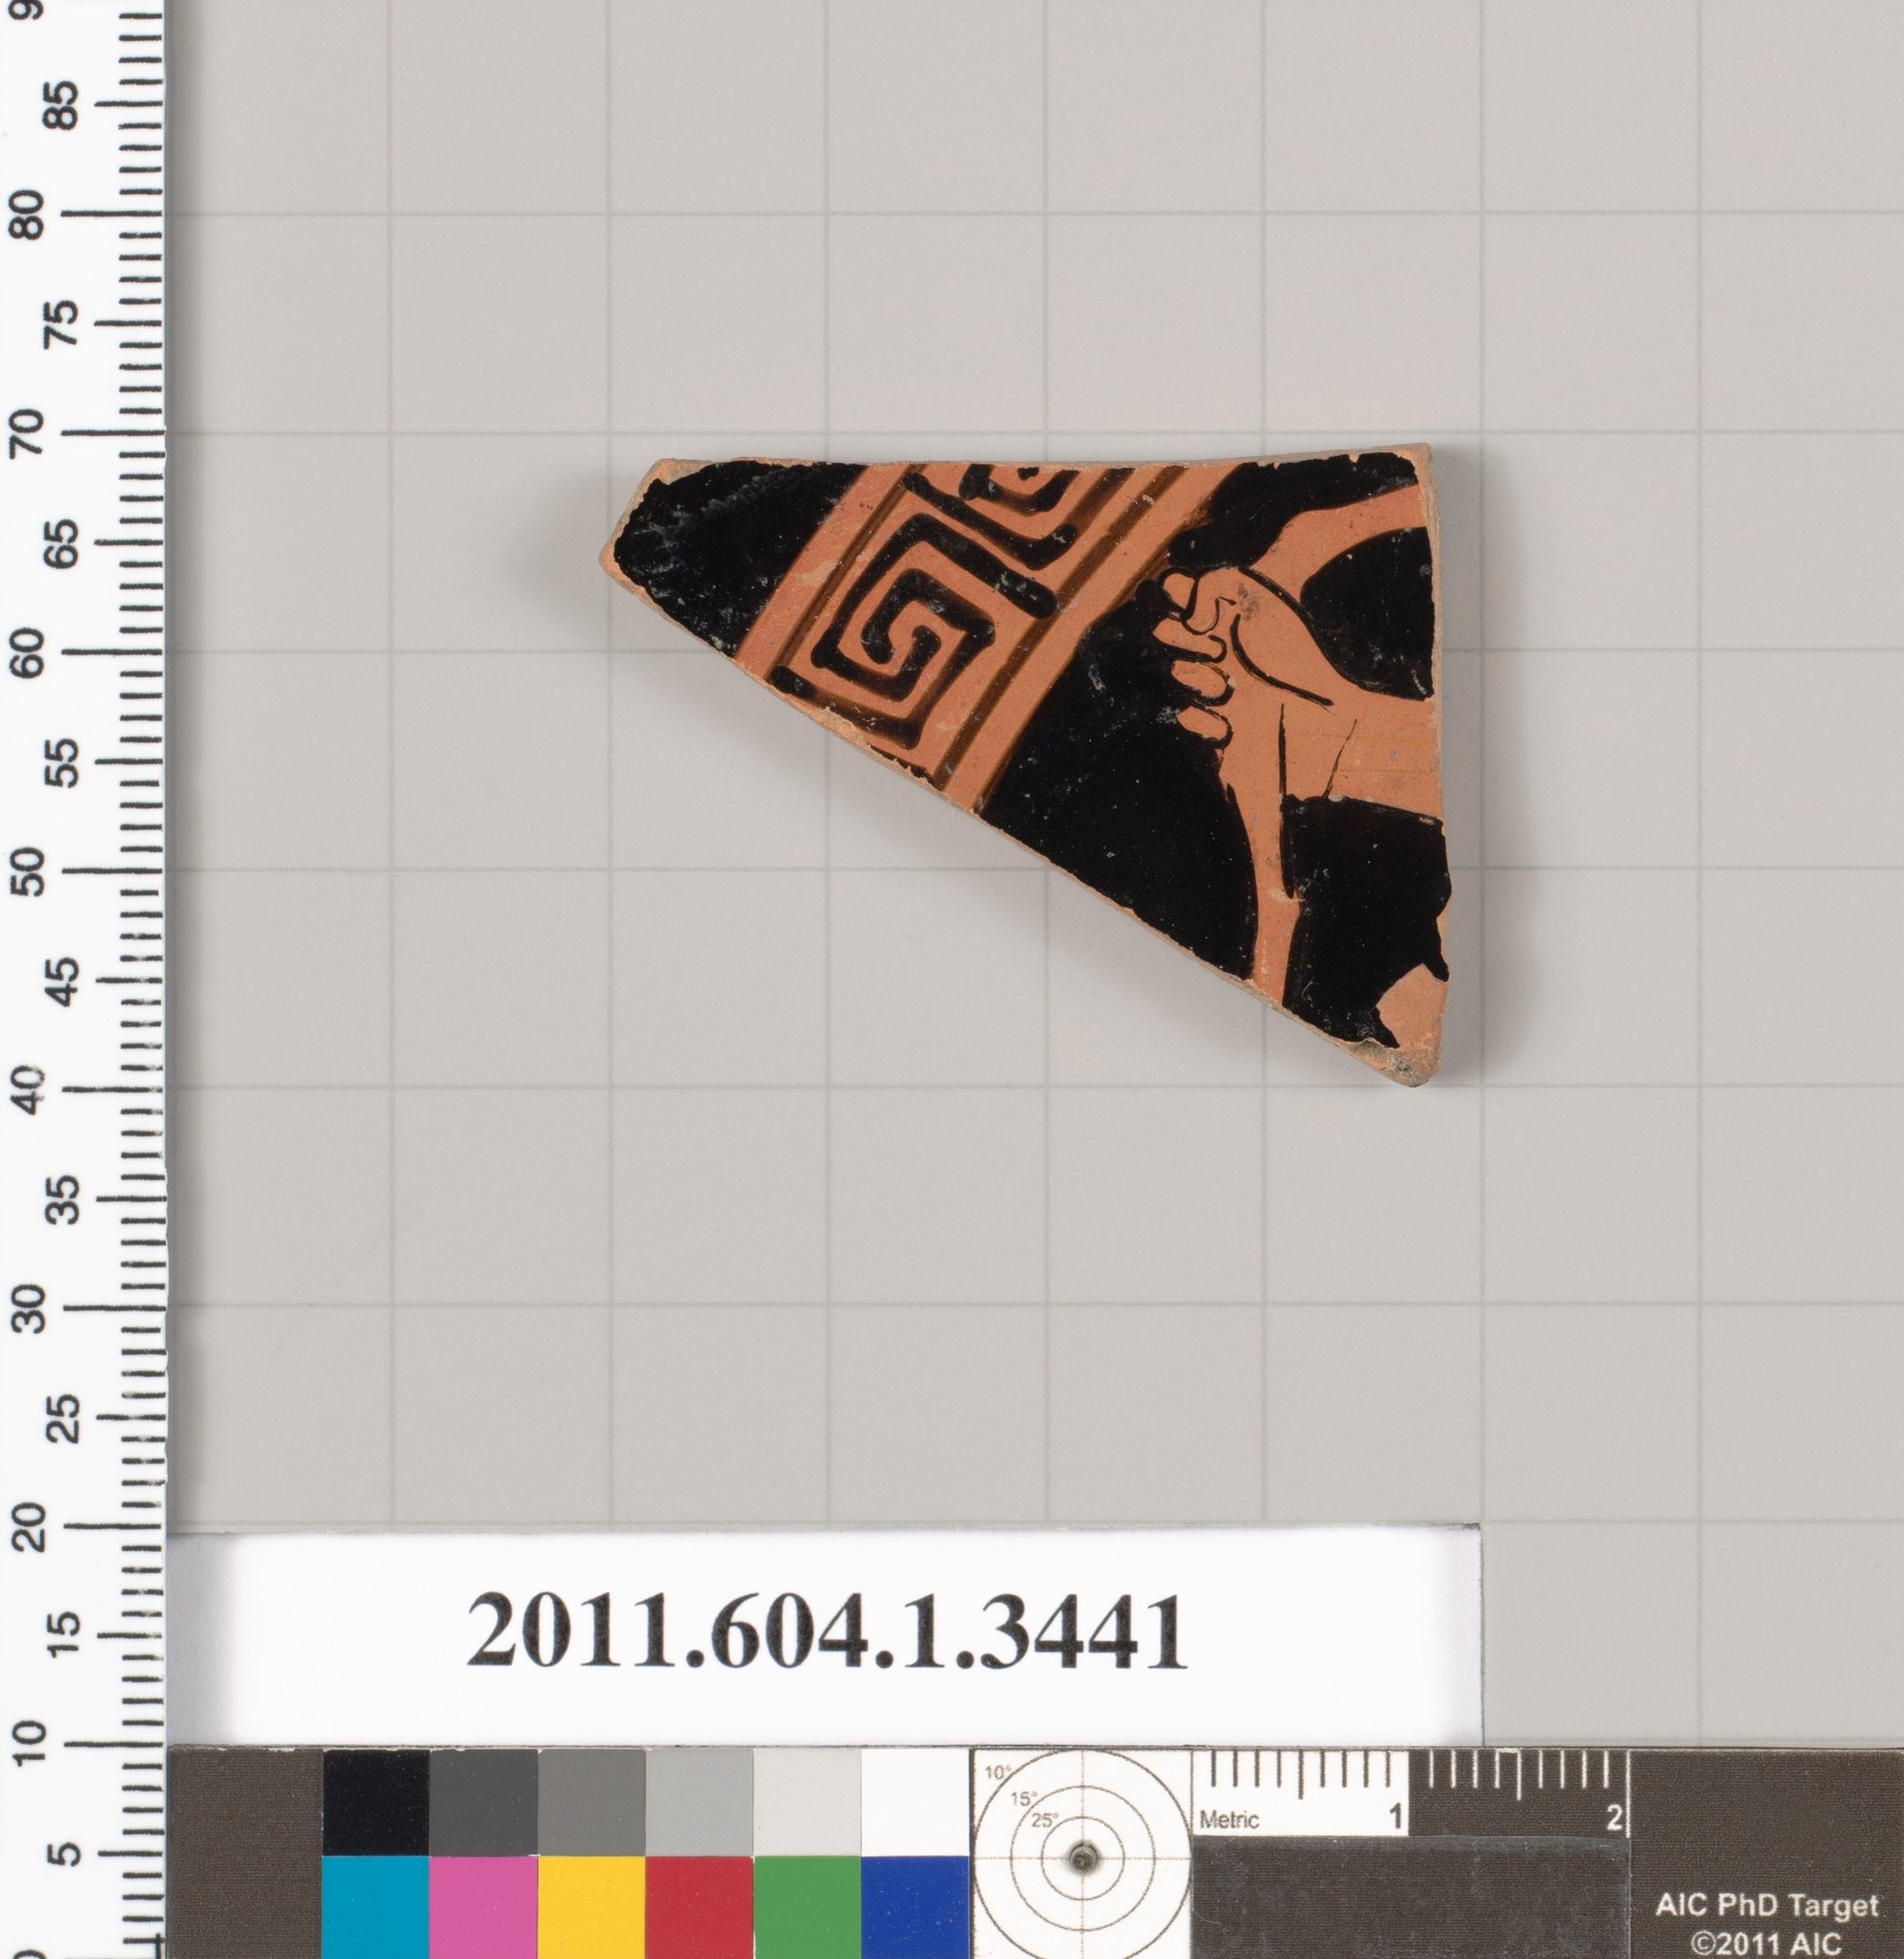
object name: kylix fragment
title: Terracotta fragment of a kylix (drinking cup)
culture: greek, attic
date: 500-475 BCE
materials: terracotta